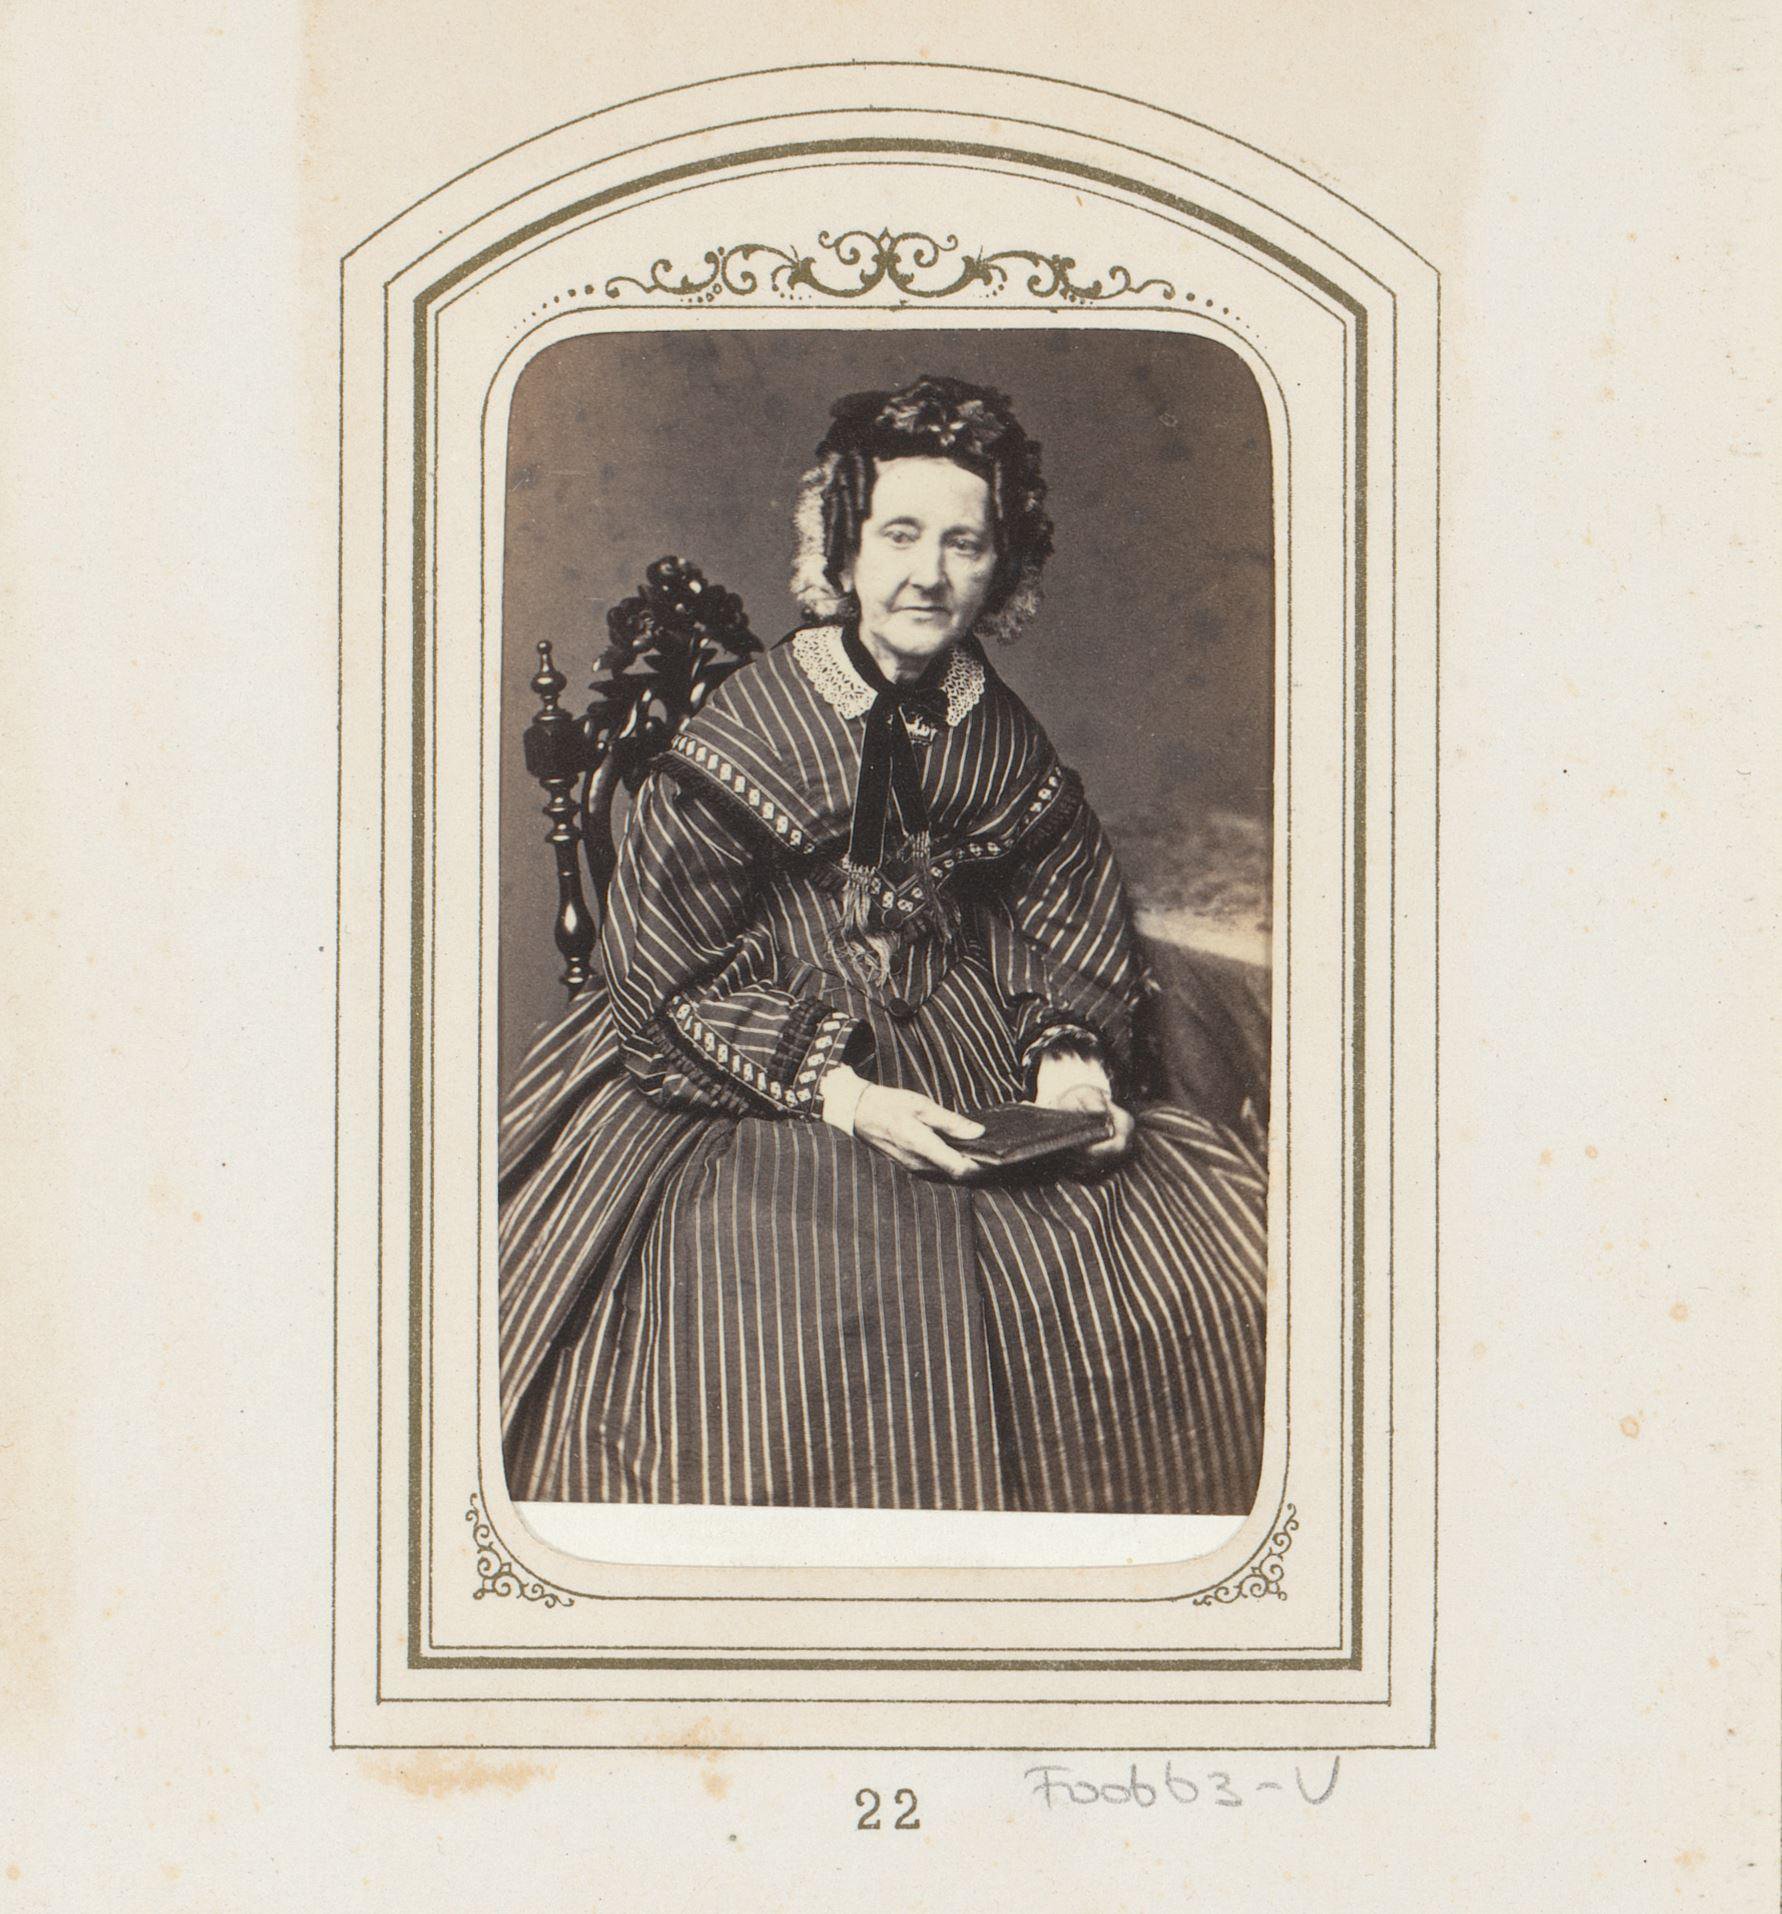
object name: carte de visite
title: Portret van een zittende vrouw in strepenjapon met muts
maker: eduard fuchs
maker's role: painter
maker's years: 1832-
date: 1860-1870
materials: cardboard, photographic support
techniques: albumen print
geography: leeuwarden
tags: historical persons - bb - woman, old woman, head-gear: cap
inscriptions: inscription: ‘Photographie/ E. Fuchs/ Leeuwarden’, number: ‘22’